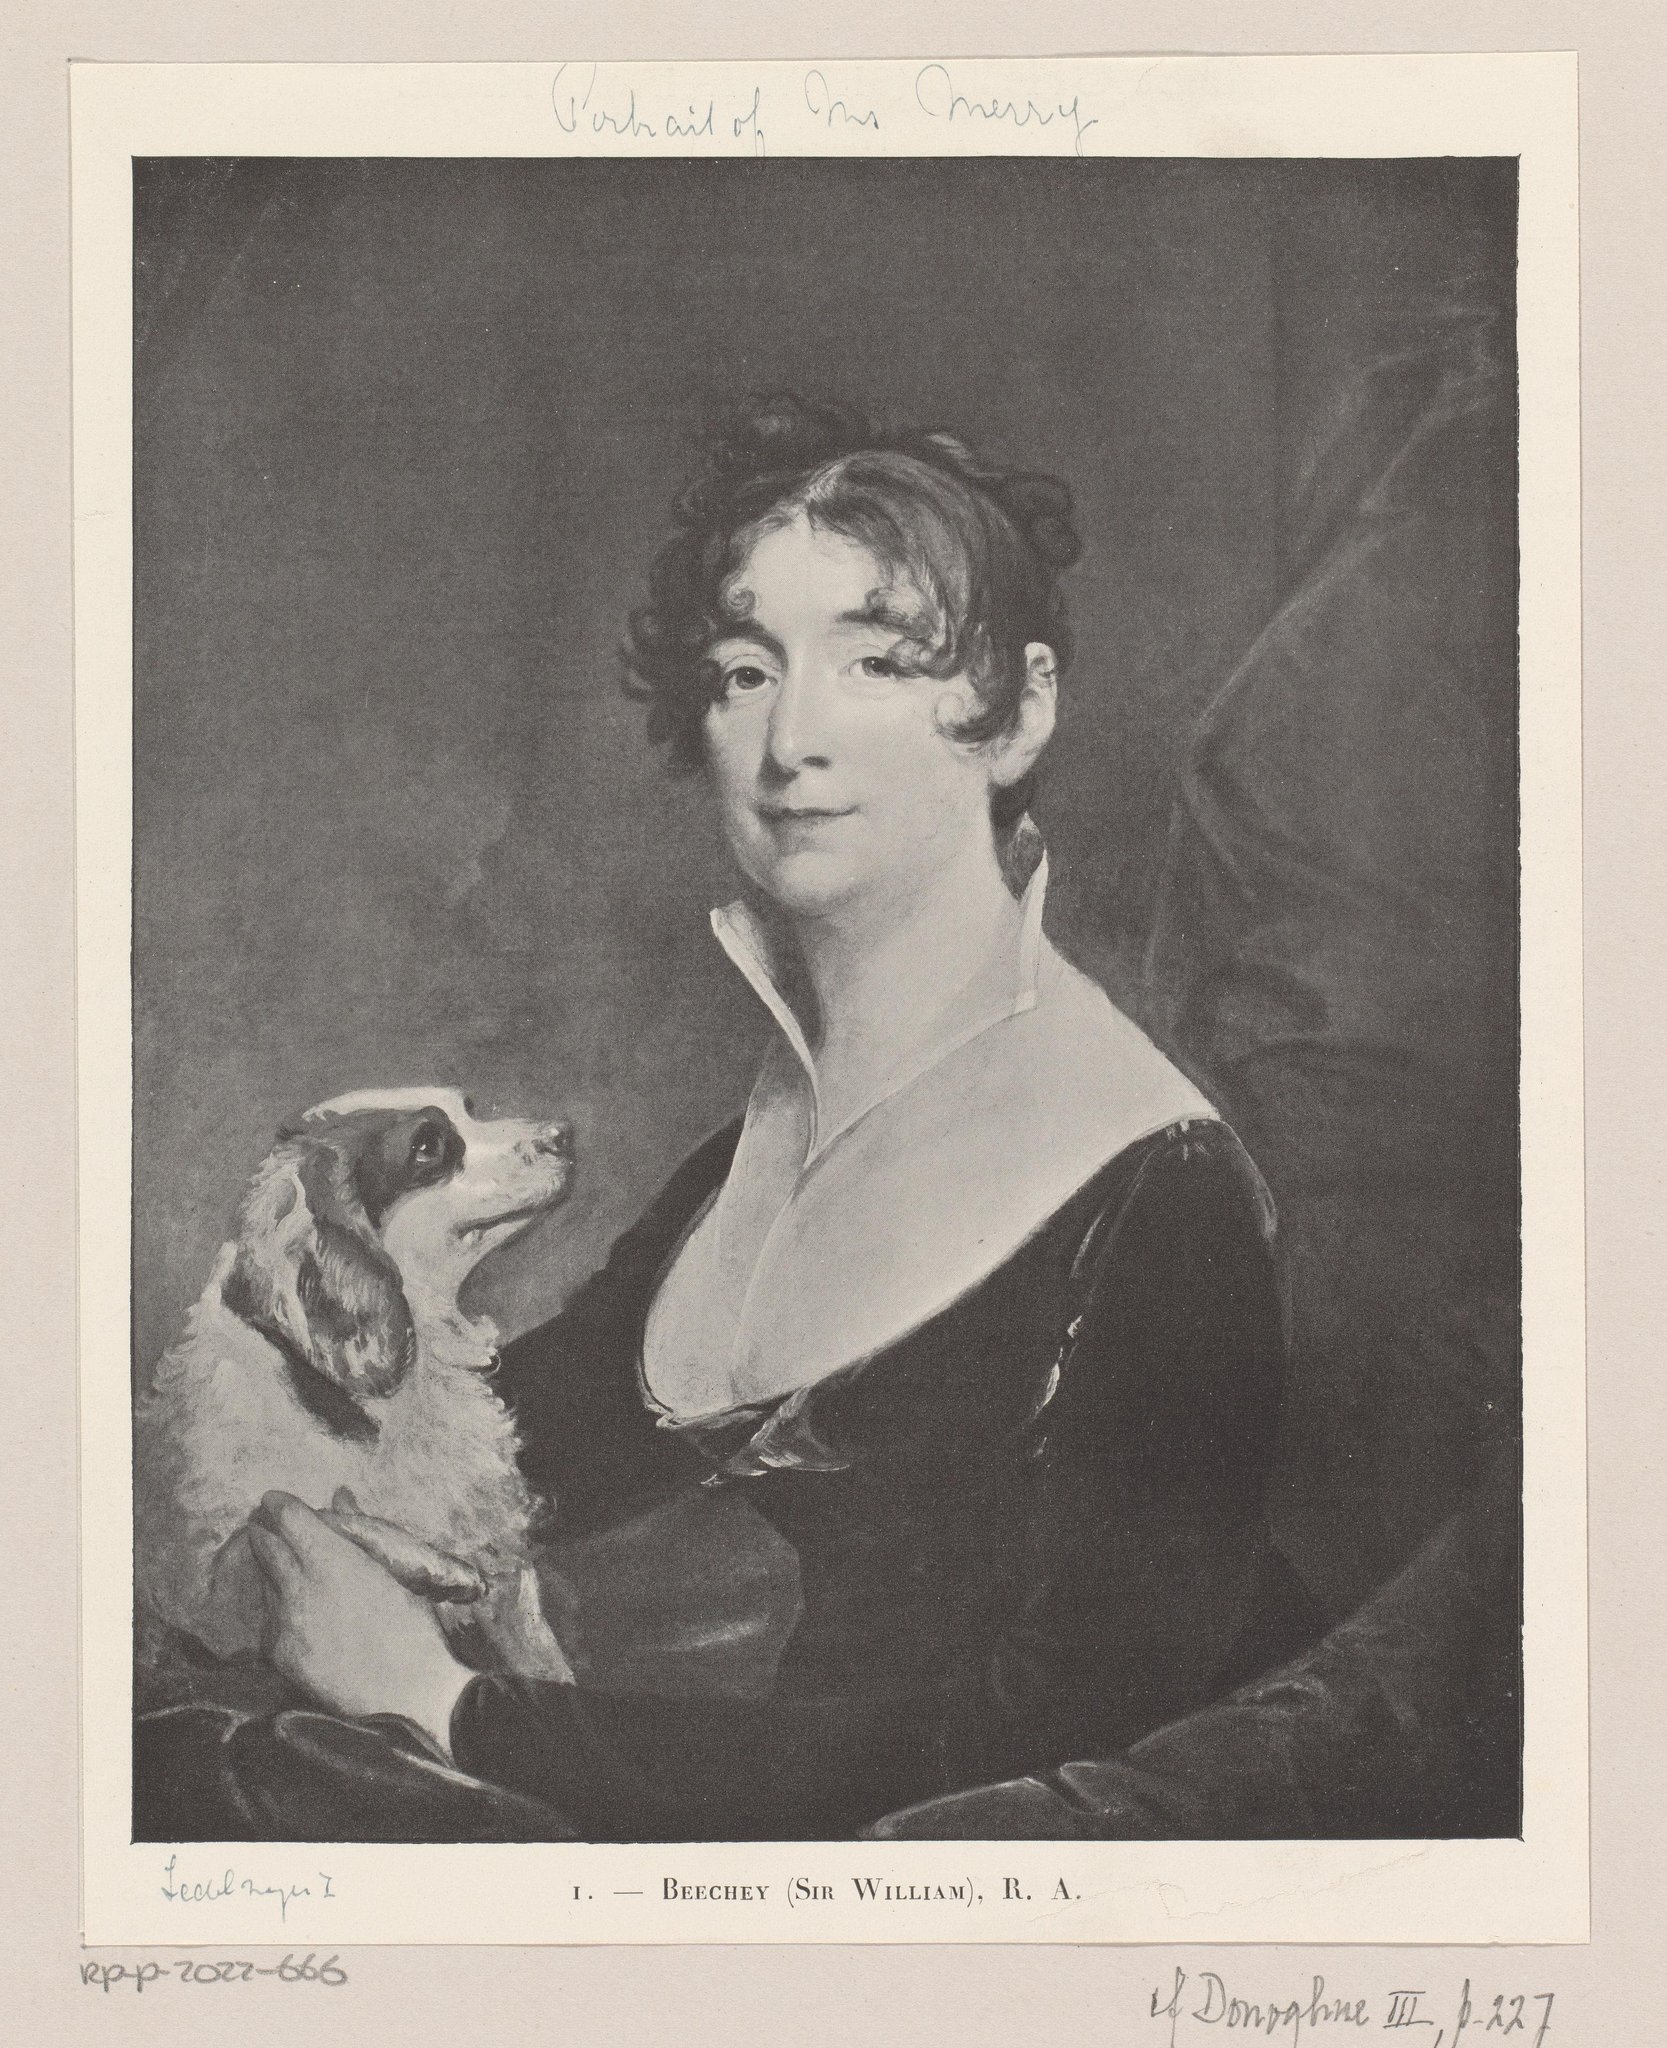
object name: photomechanical print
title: Portret van Ann Brunton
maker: Anonymous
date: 1907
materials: paper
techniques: autotype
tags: historical persons - bb - woman, portrait of actor, actress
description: Afdruk uit: Tableaux composant la Collection Ch. Sedelmeyer (...). Parijs: s.n., 1907, dl. 1, p. 3.